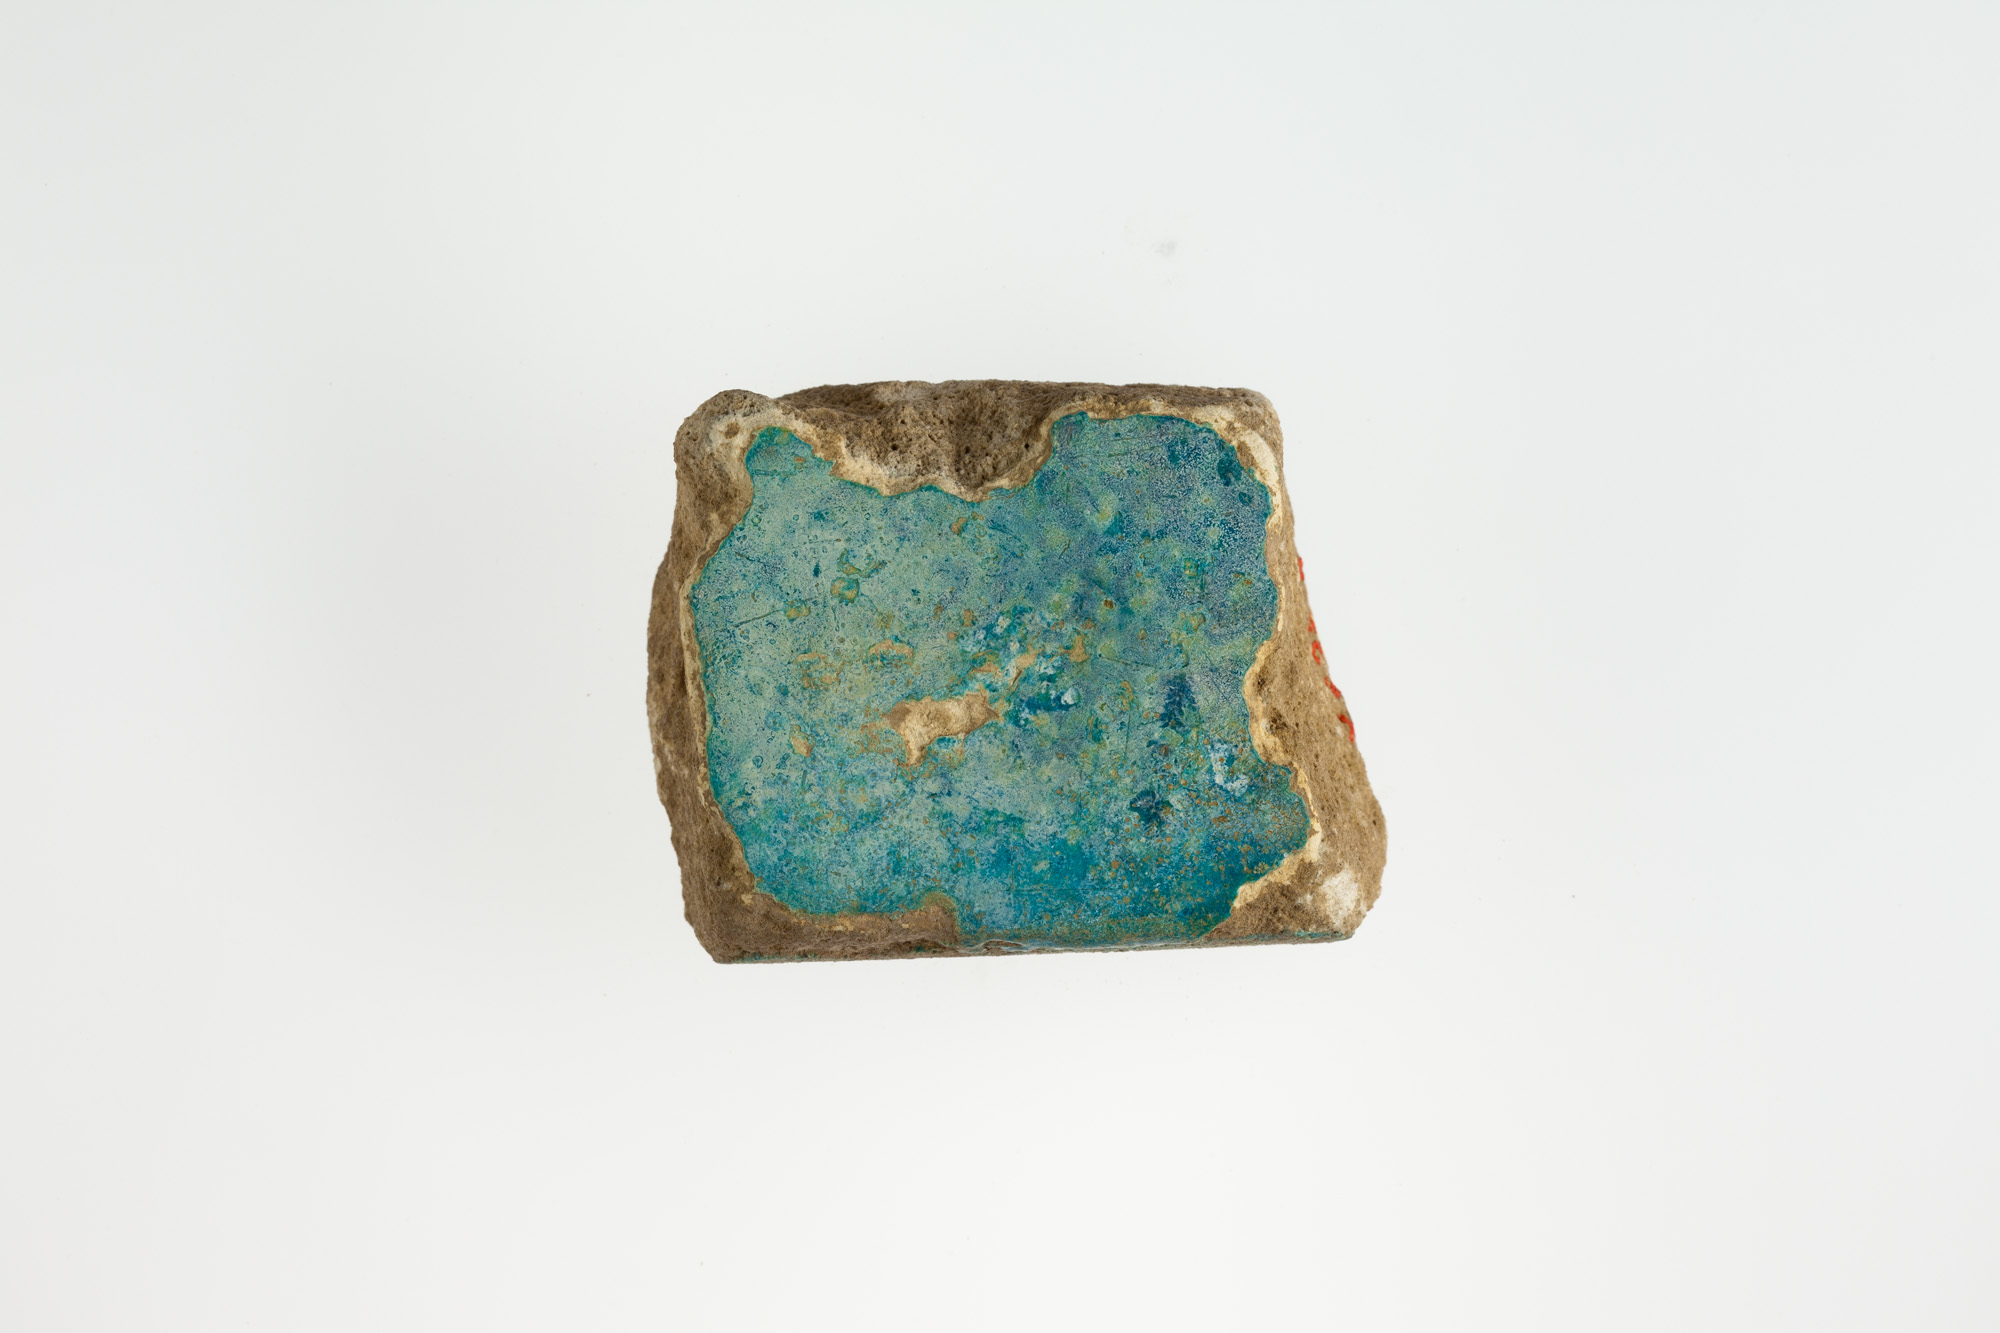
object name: tile fragment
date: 1981-1640 BCE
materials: faience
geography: egypt